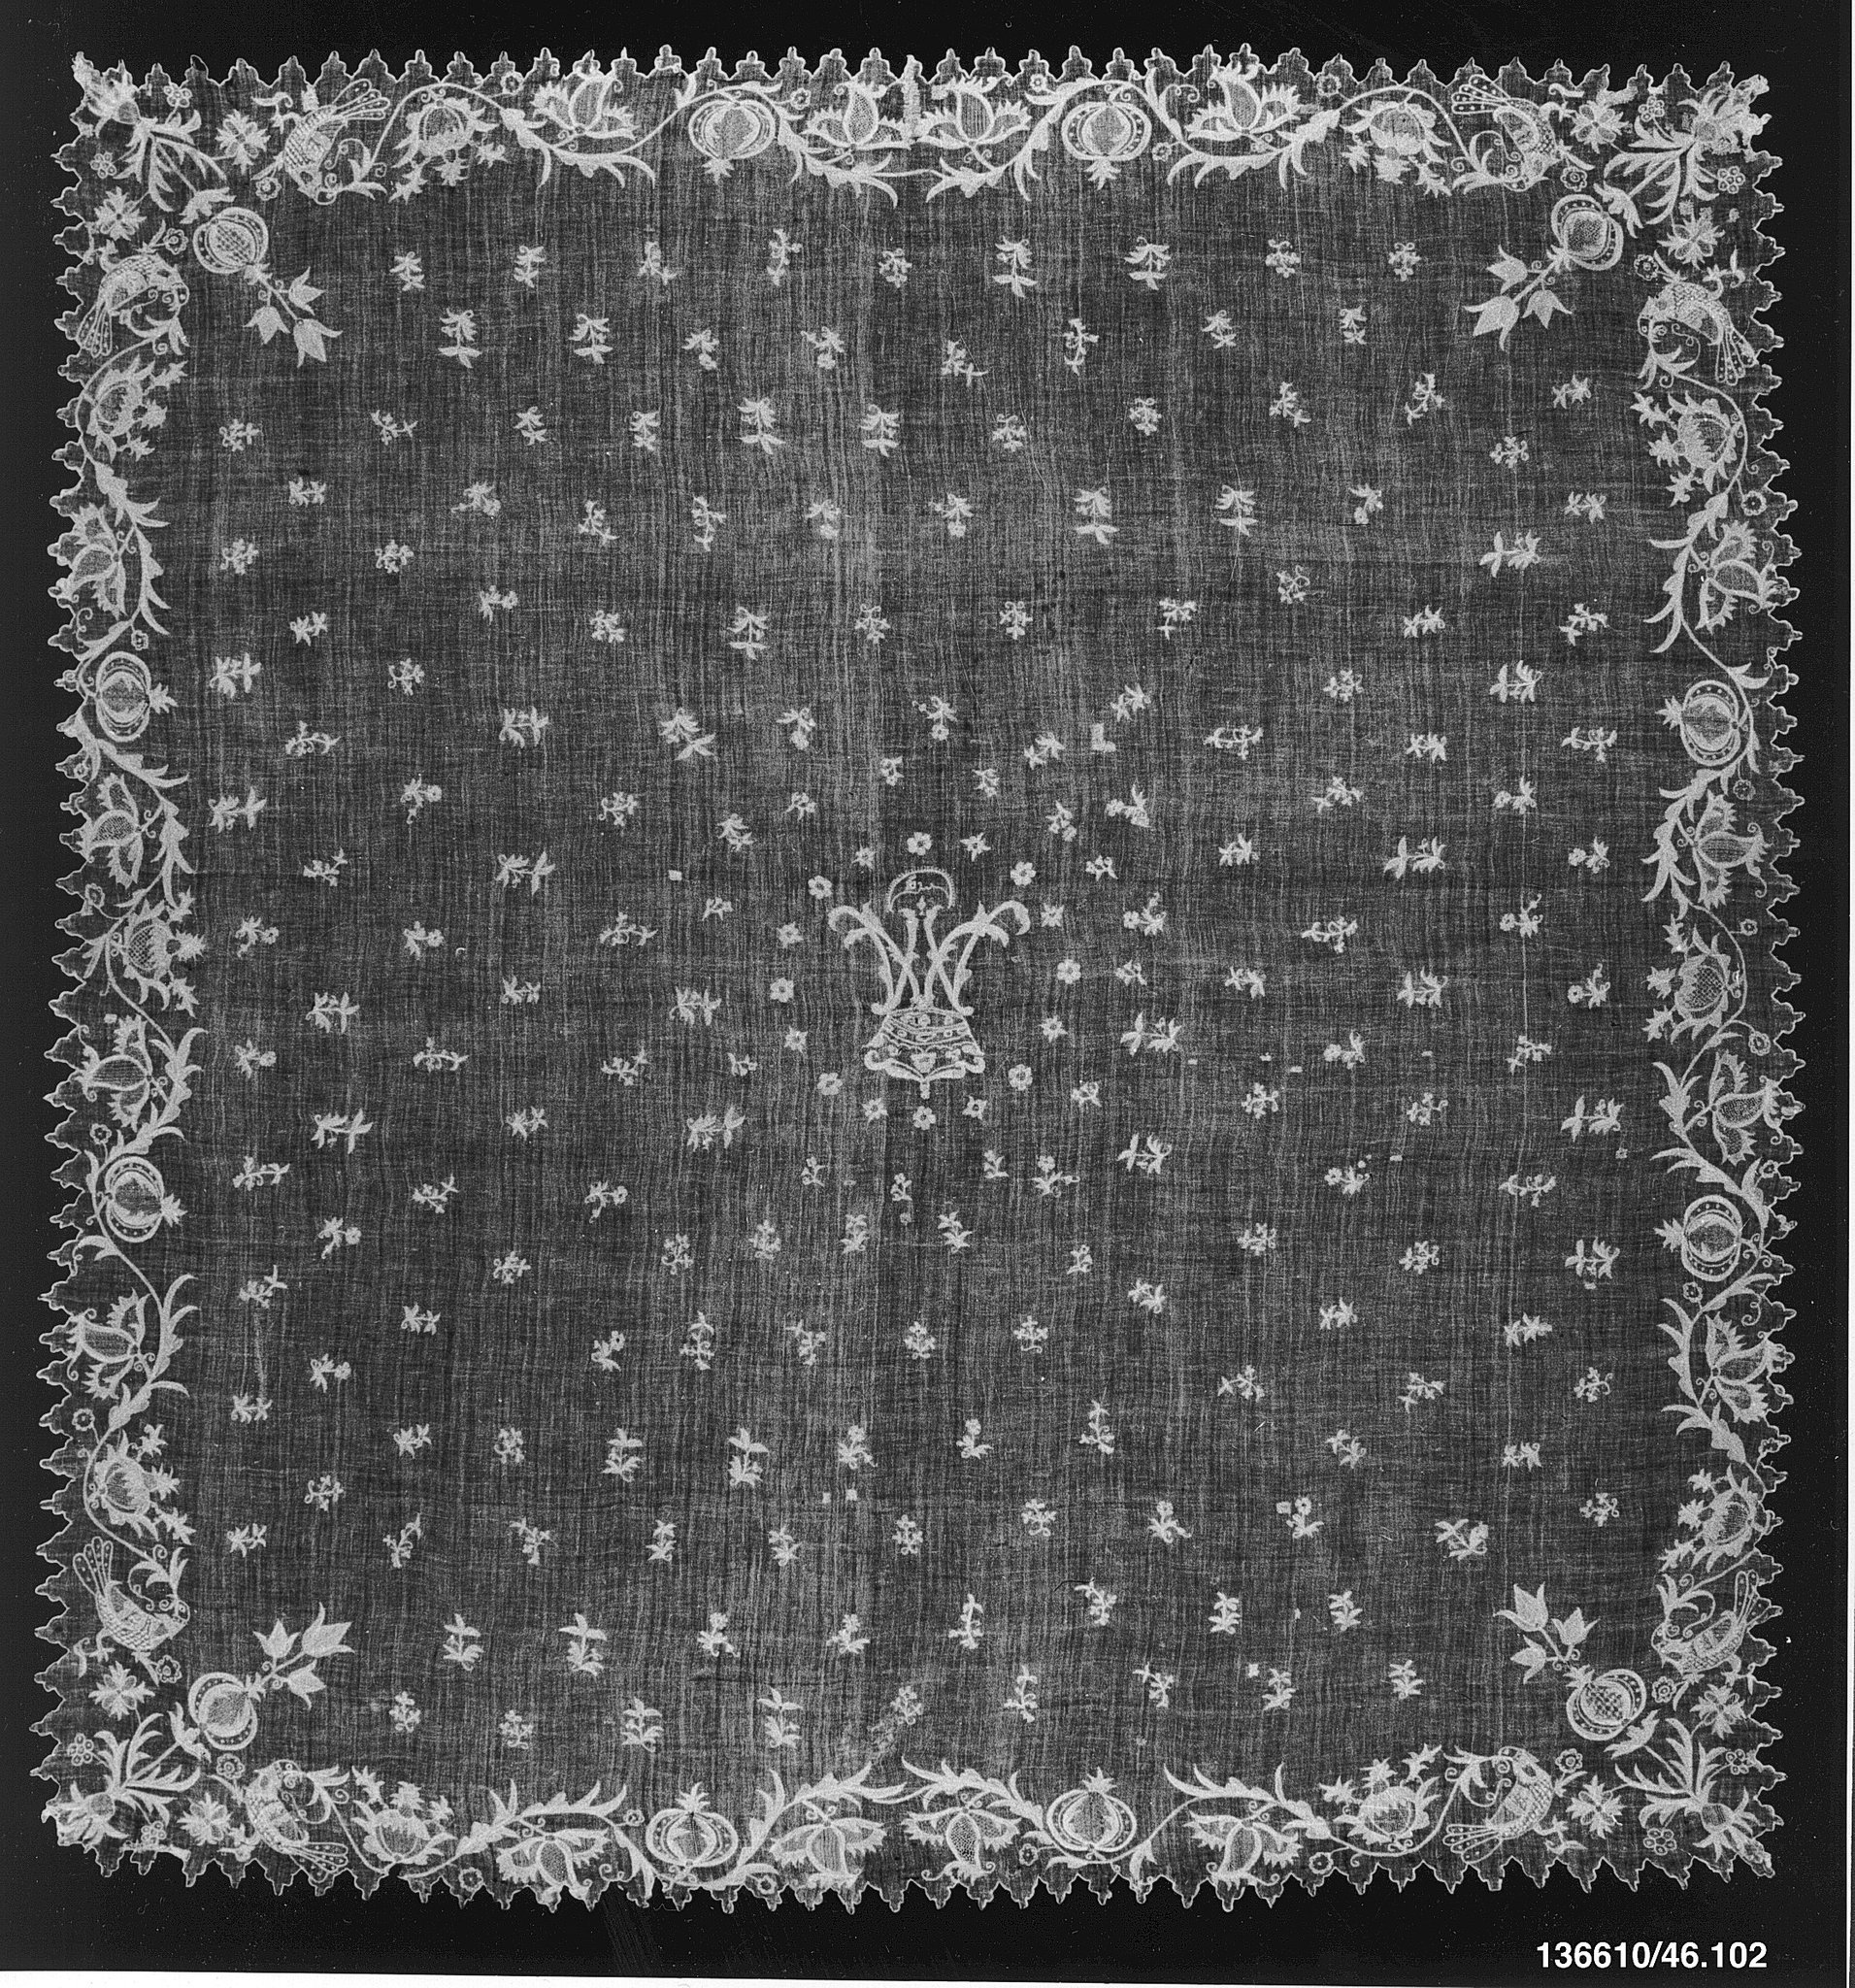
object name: square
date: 1701-1733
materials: cotton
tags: flowers